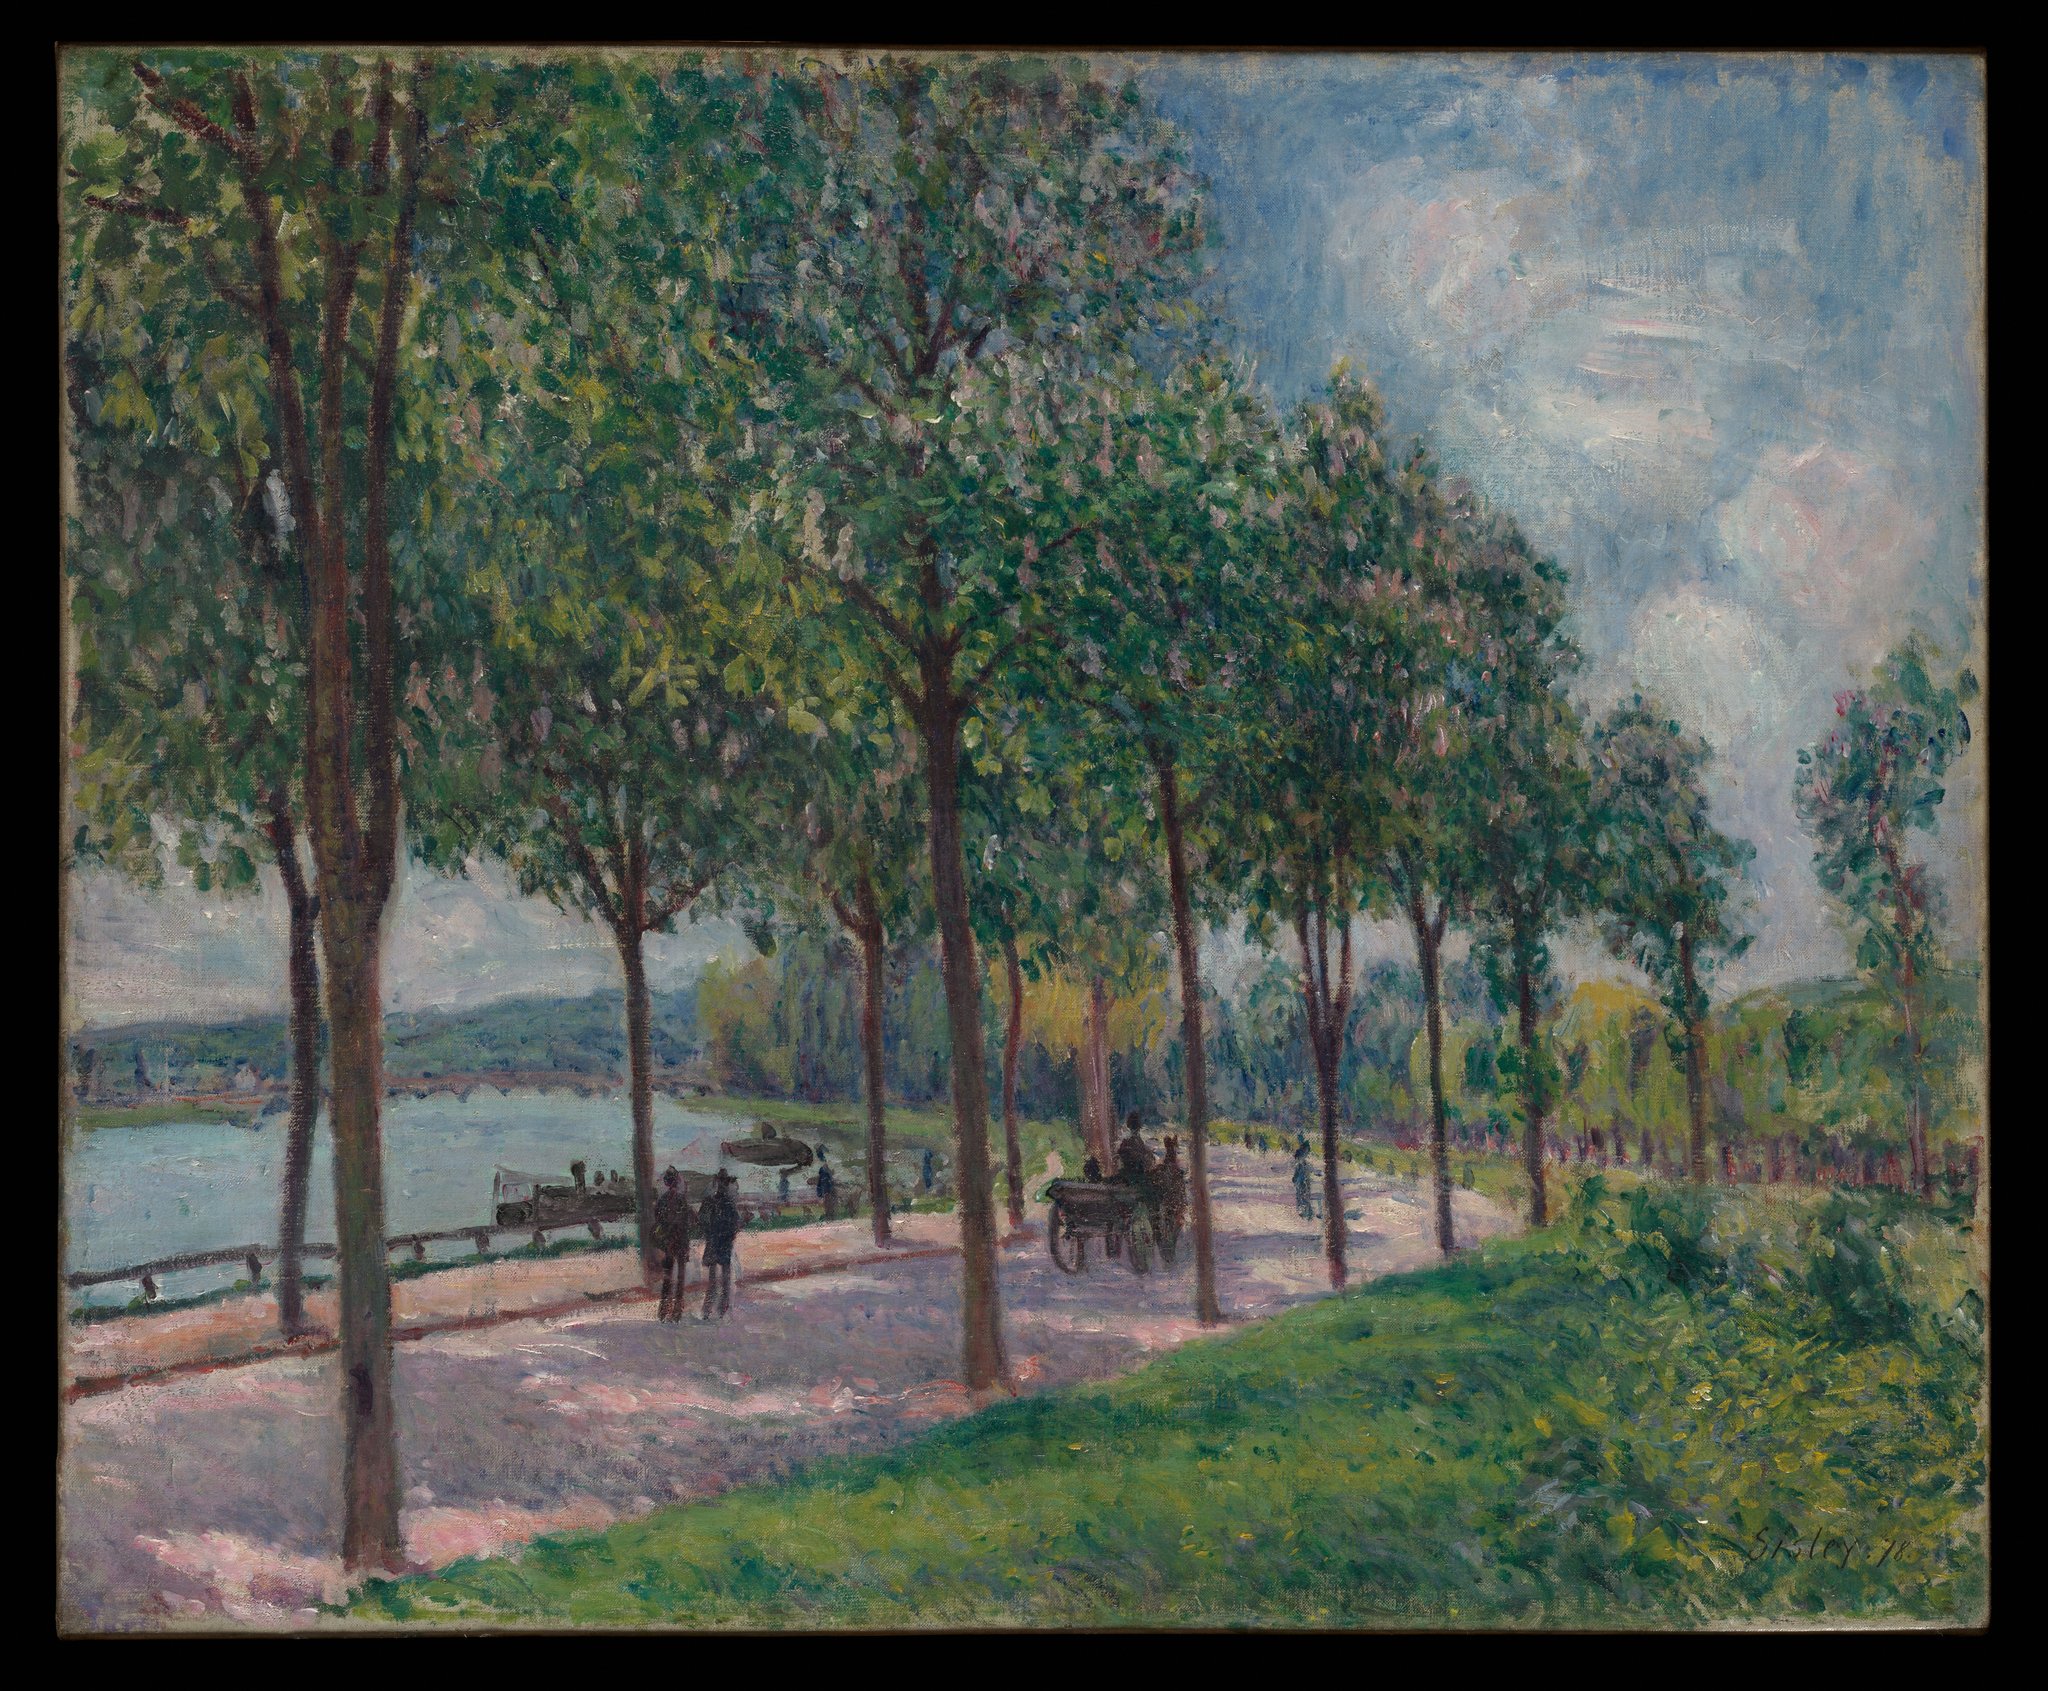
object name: painting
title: Allée of Chestnut Trees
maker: alfred sisley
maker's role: artist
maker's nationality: british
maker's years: 1839-1899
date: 1878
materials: canvas, oil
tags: rivers,trees